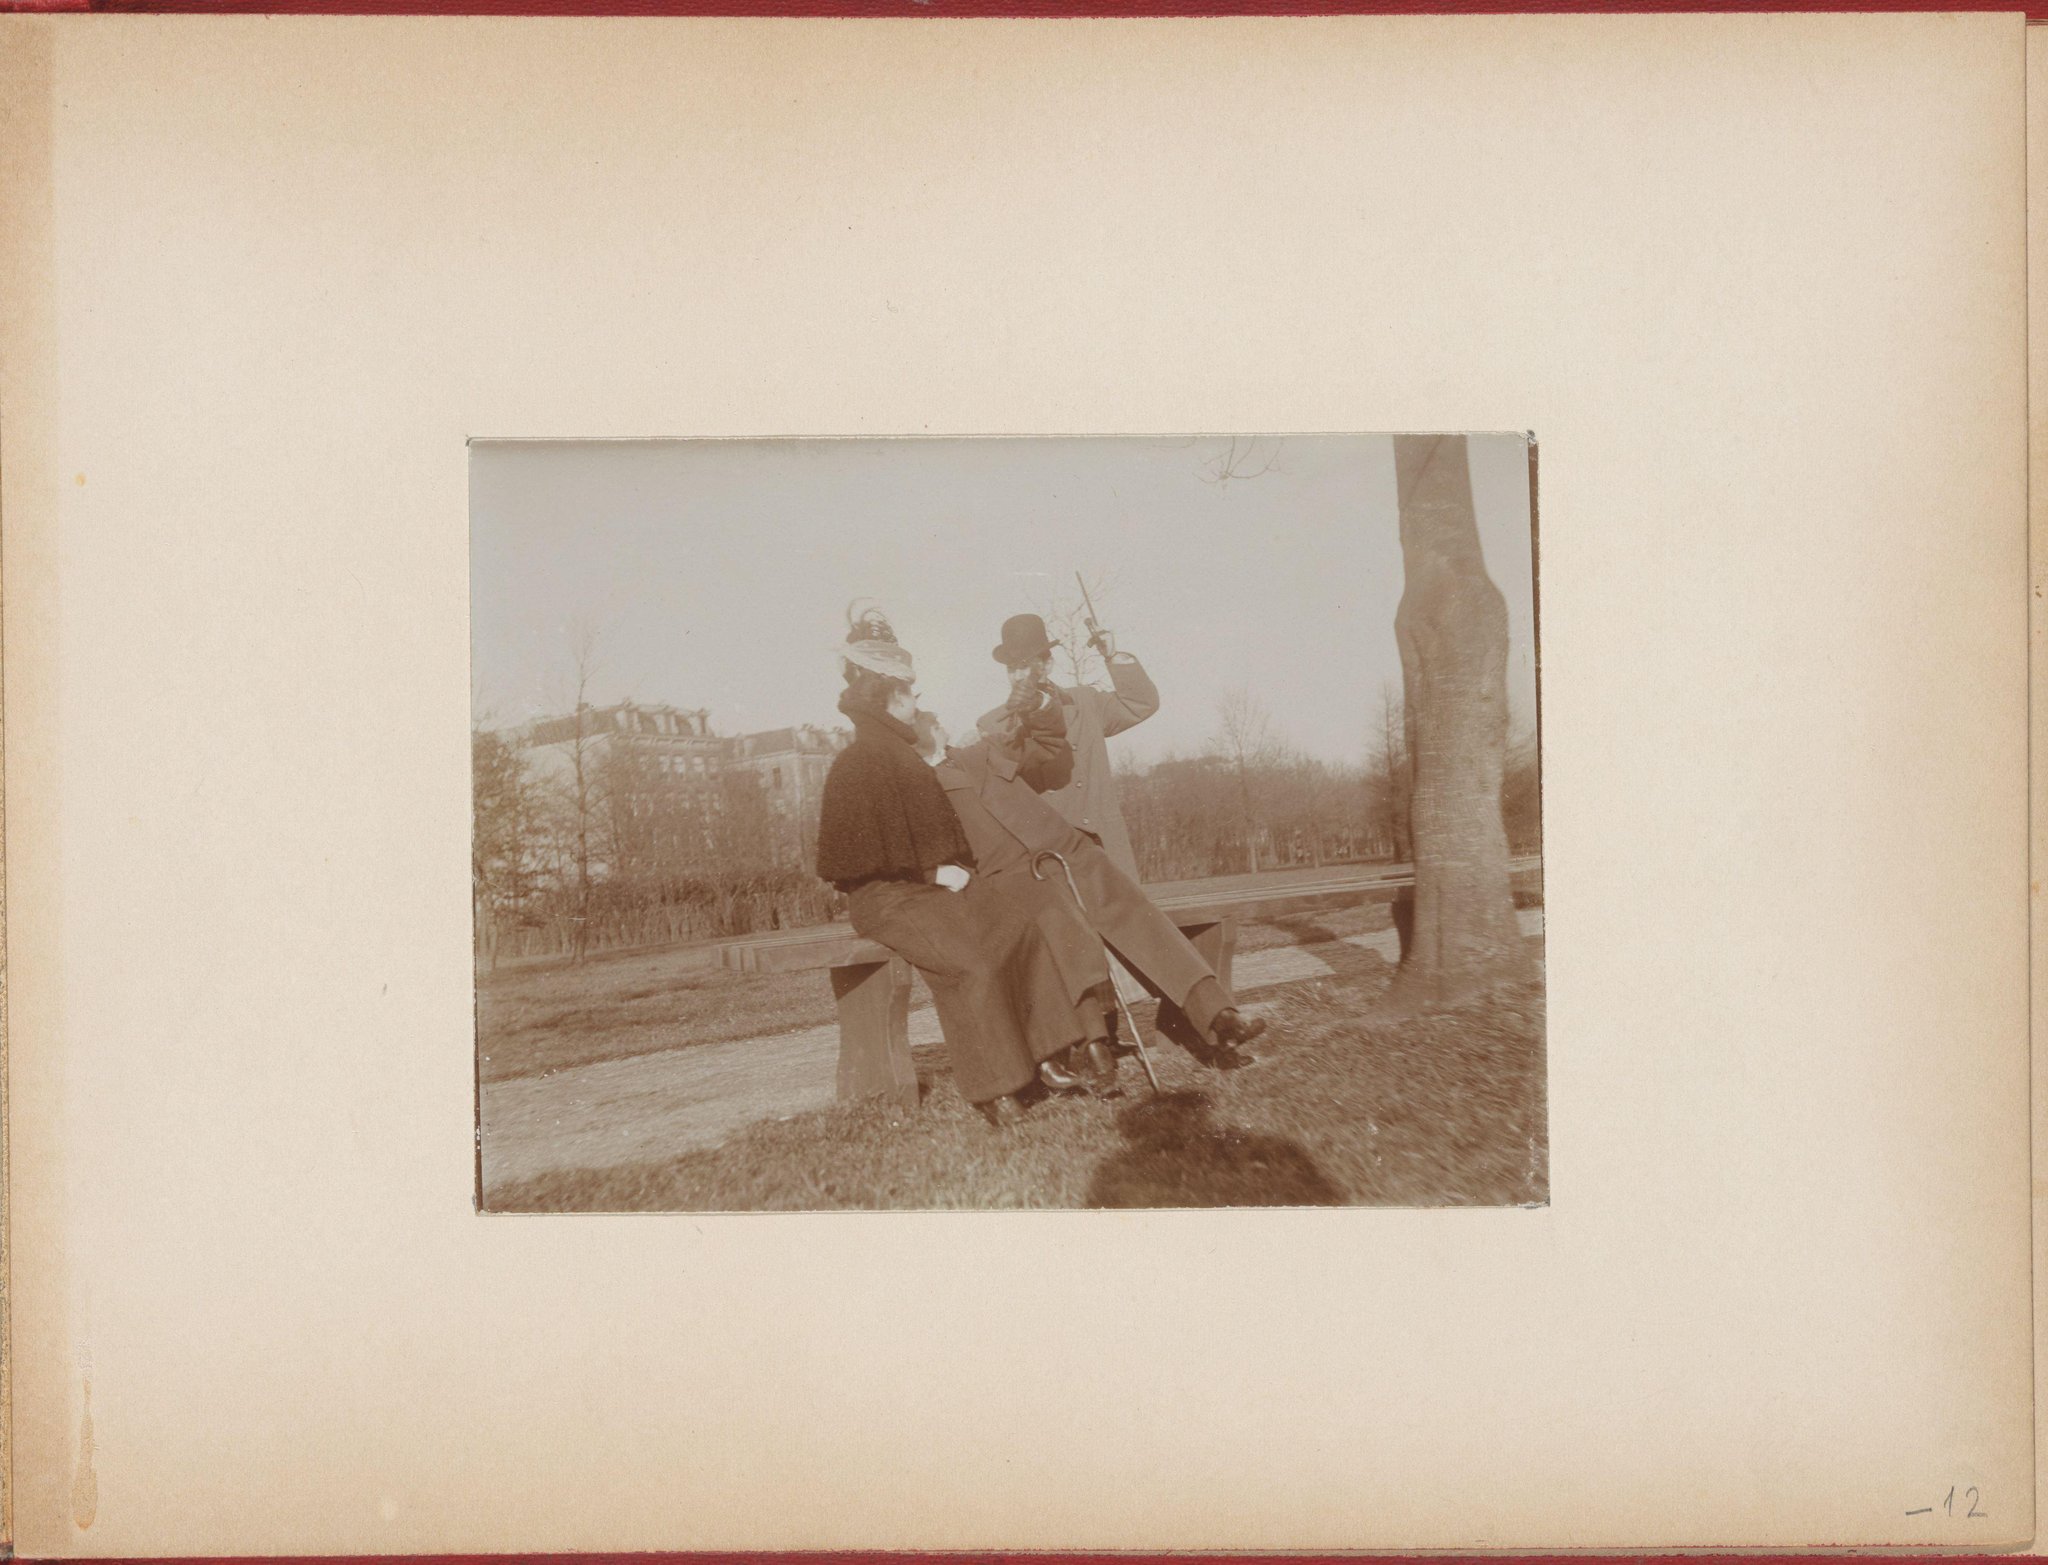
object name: photograph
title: Jong stel, de vrouw met hoed met veren, op een bankje in een park, de man die haar begluurde wordt door de andere man met zijn wandelstok geslagen, , fotoverhaal 4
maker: gerard aalbersberg (us)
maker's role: amateurfotograaf, arts, chirurg, gynaecoloog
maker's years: 1870-1934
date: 1899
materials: paper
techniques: photography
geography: amsterdam